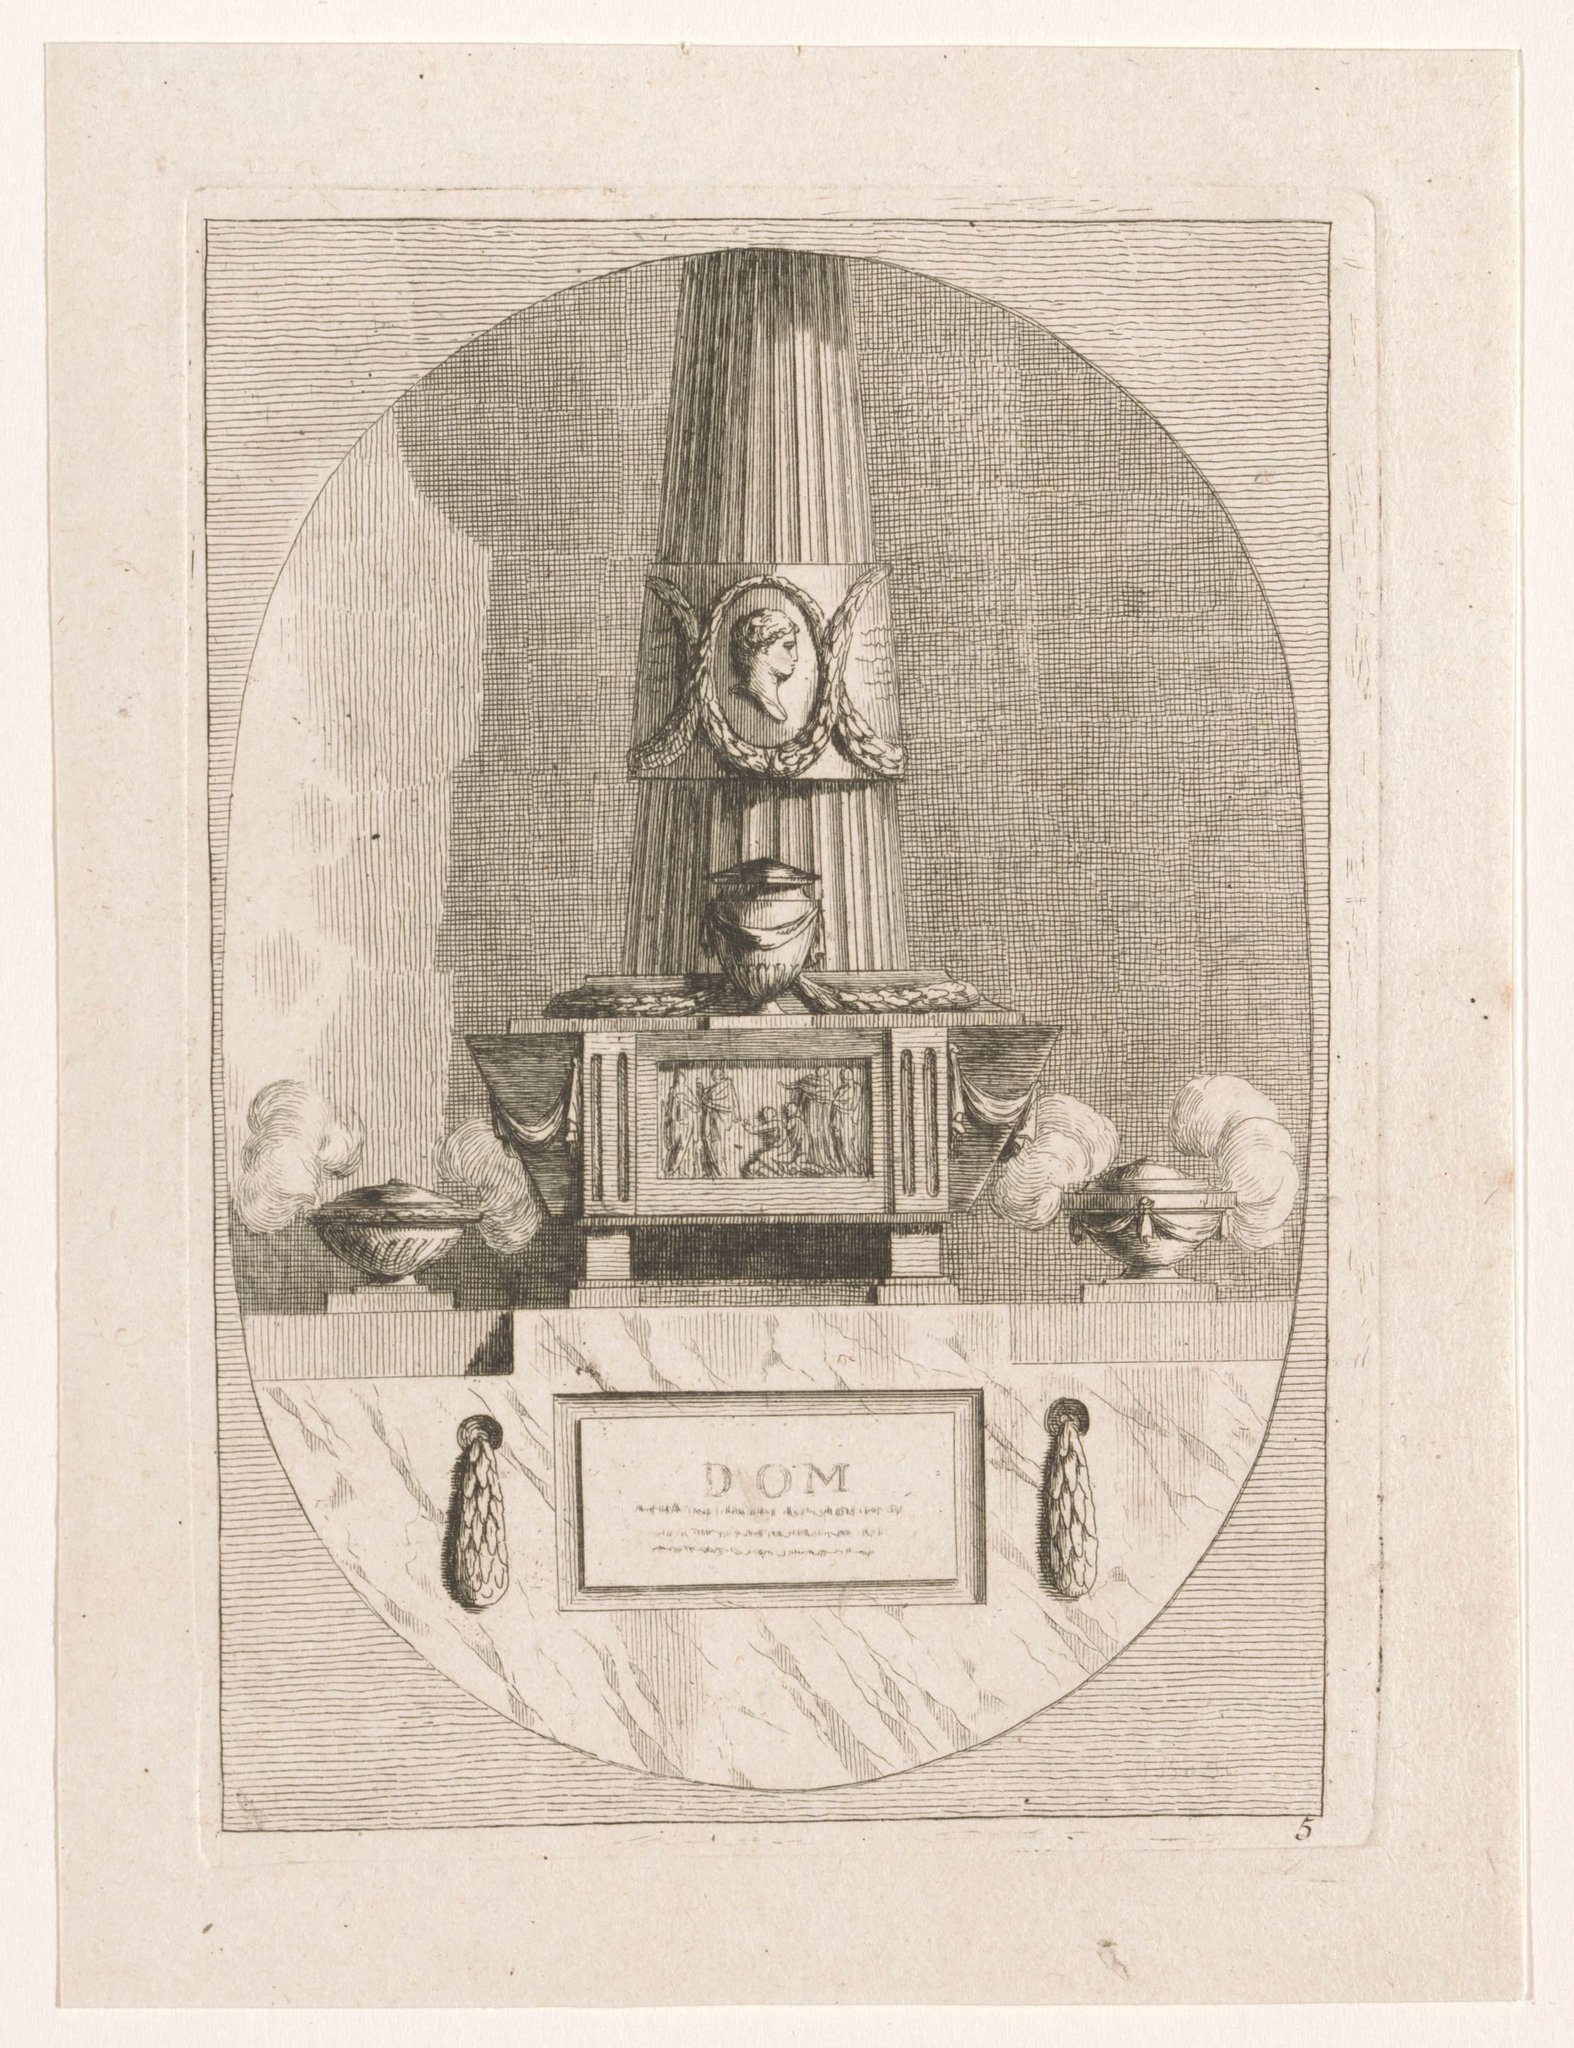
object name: print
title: Tombe met obelisk en rookvaten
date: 1755-1782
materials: paper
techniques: etching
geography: paris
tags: incense-burner ~ scents, perfumes, façade (of house or building), needle, obelisk (marking grave)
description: Een tombe met een zuil met medaillons, aan weerszijden van de tombe staan rookvaten.